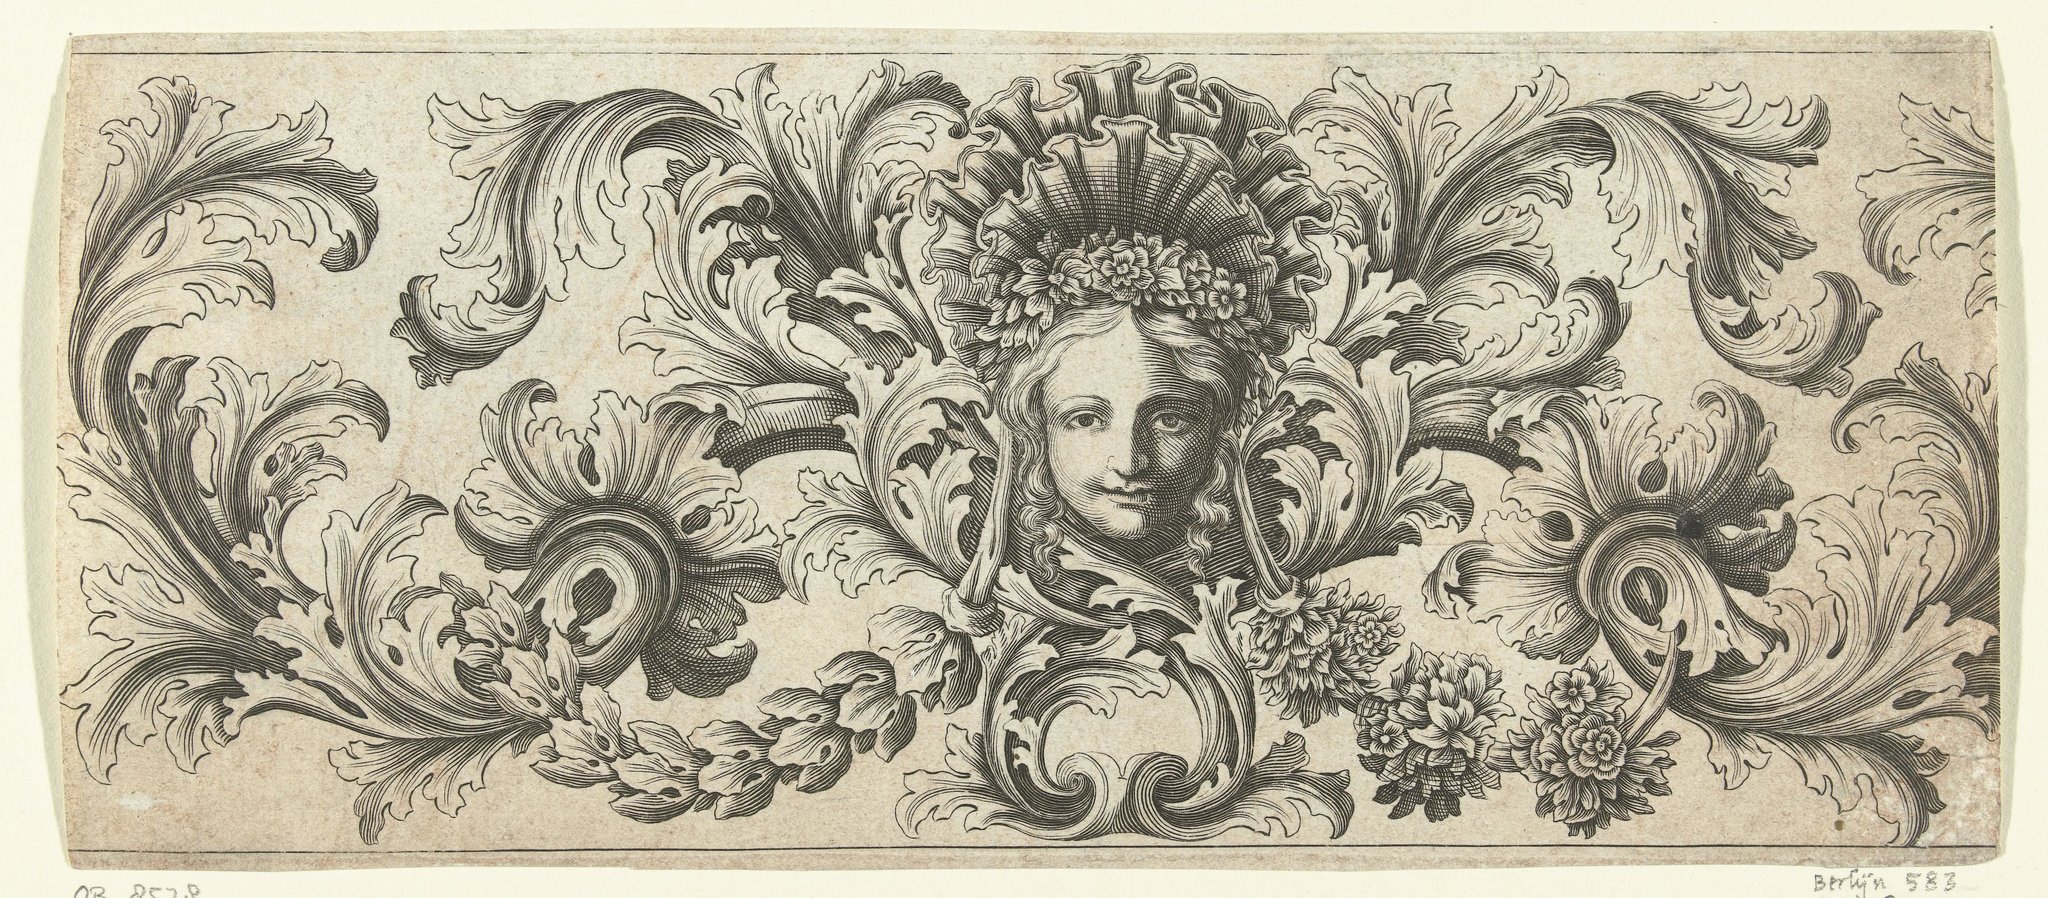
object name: print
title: Friezen met bladranken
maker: giovanni marco paluzzi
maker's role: publisher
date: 1656-1660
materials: paper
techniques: engraving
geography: rome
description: Links van het masker bevindt zich een guirlande van bladeren, rechts een gurilande van bloemen en bladeren. Blad 5 uit serie van 12 bladen.